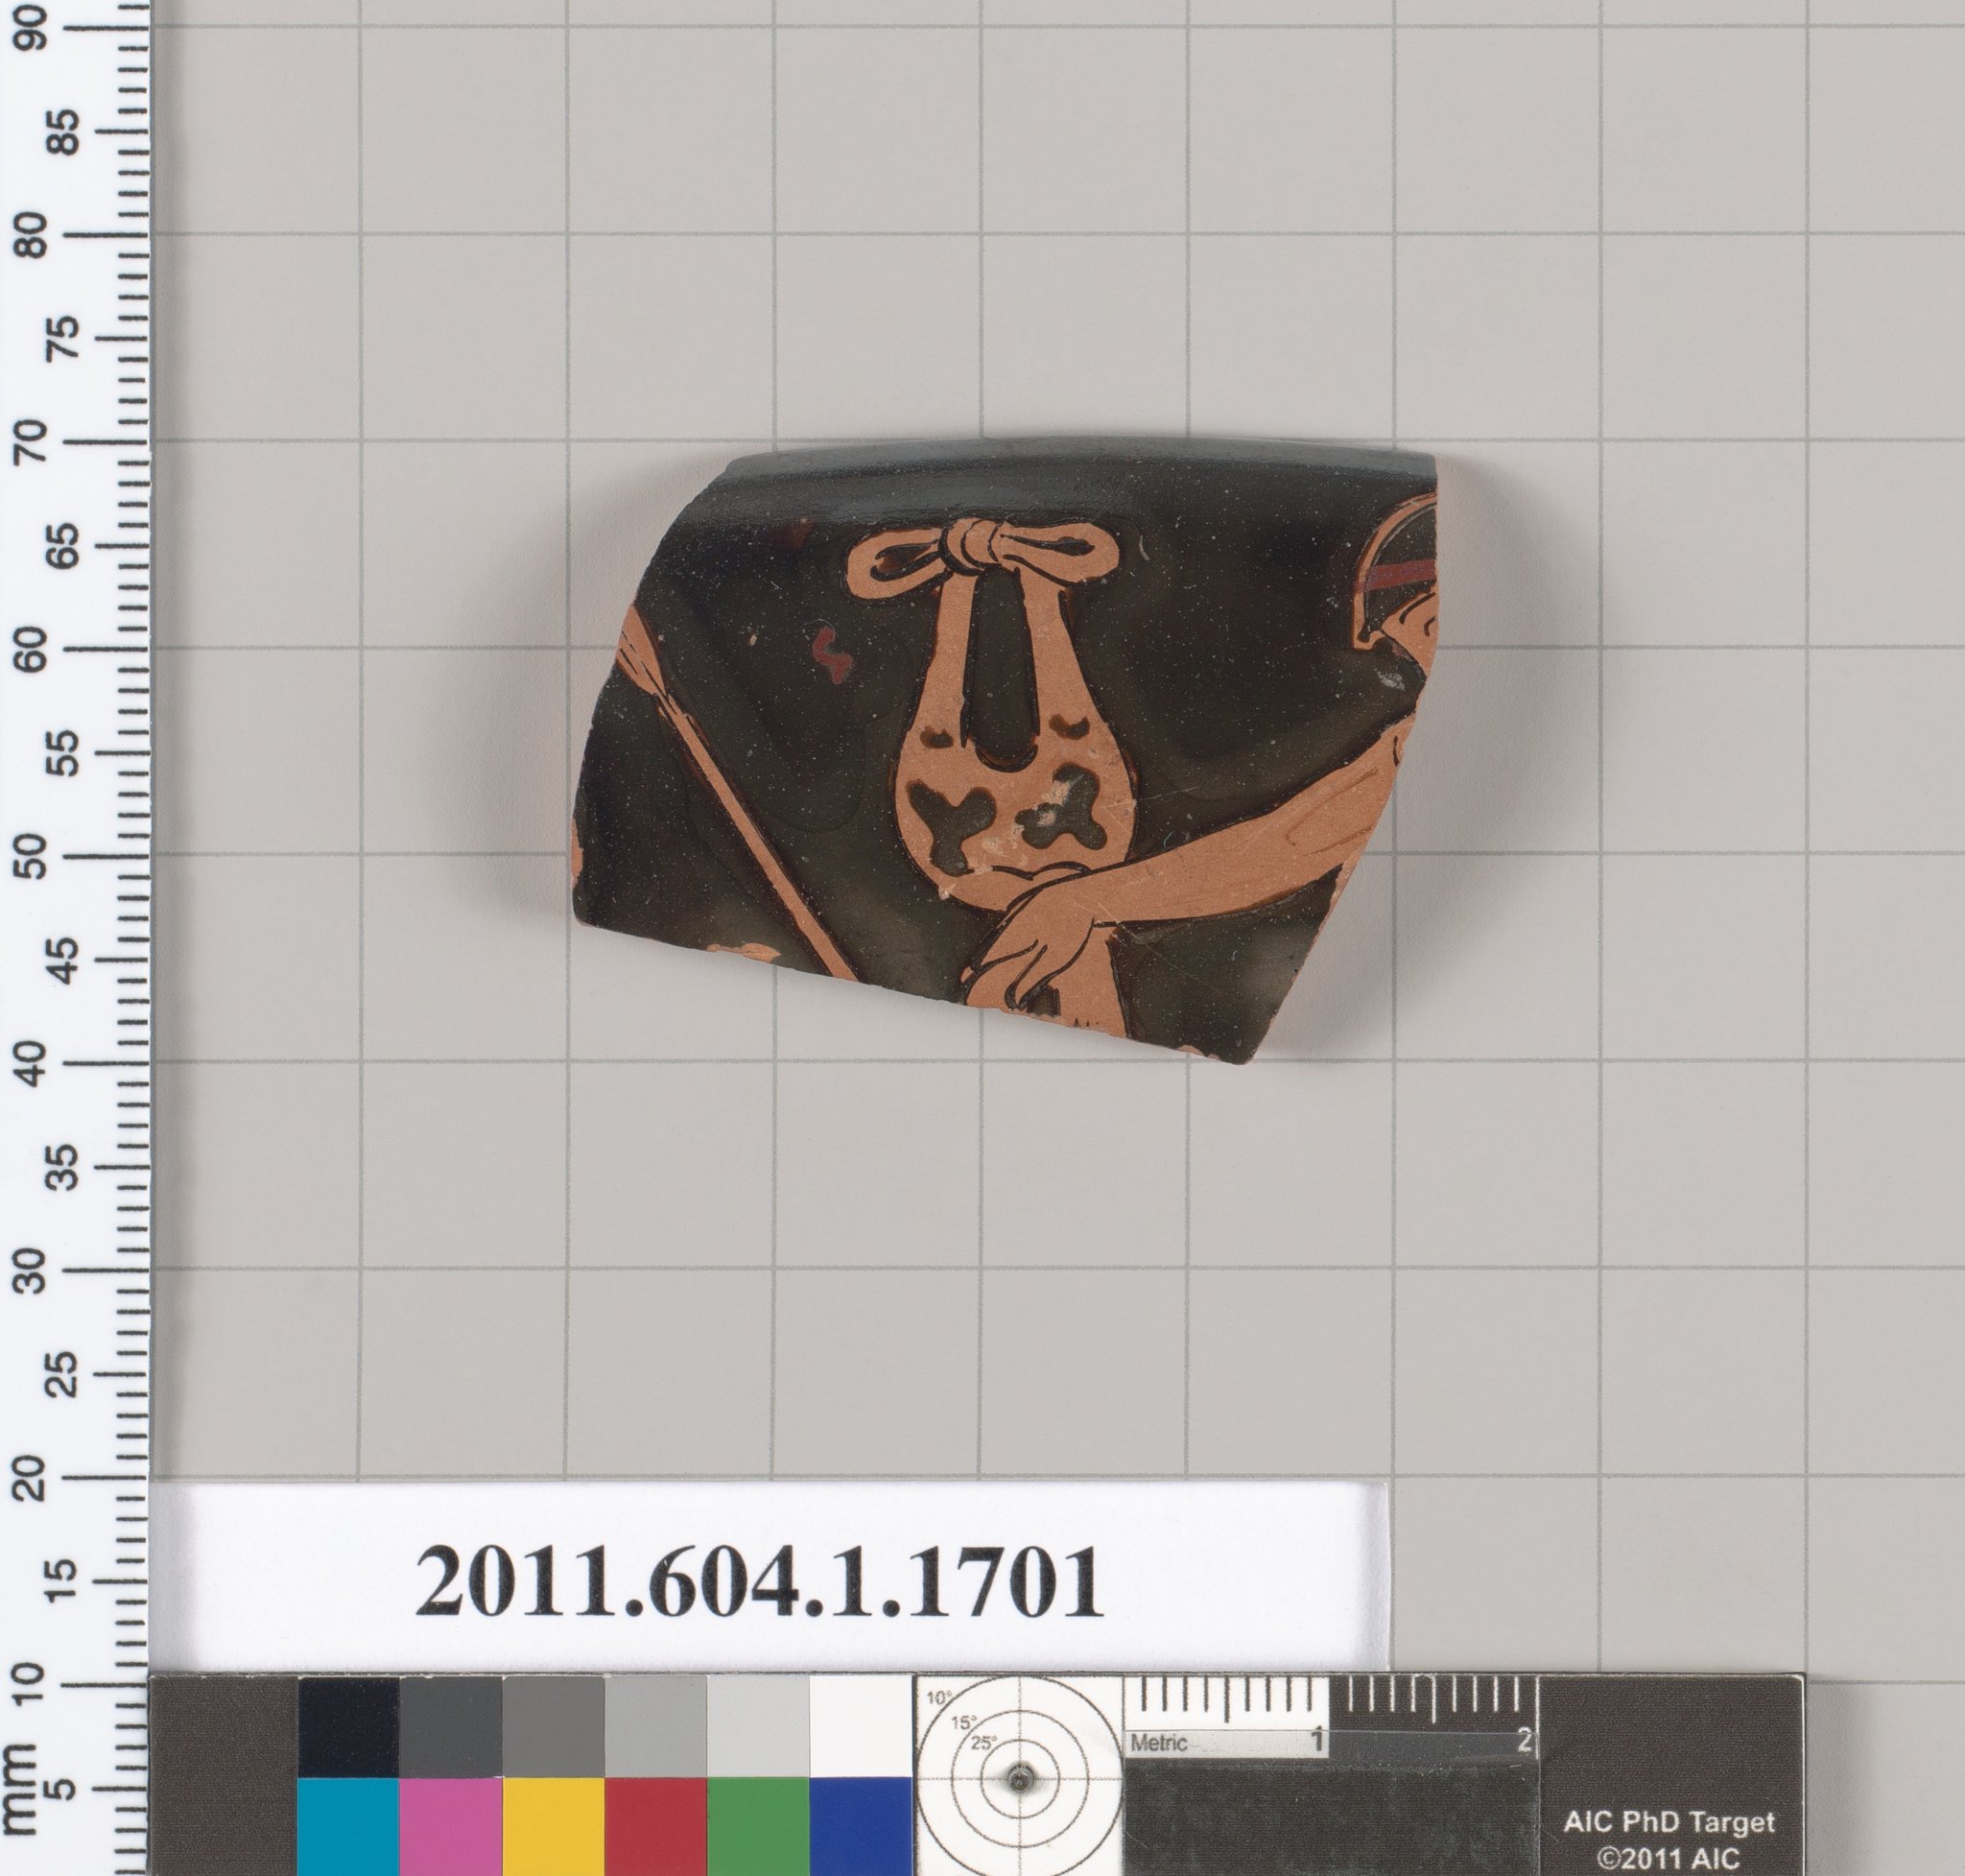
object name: kylix fragment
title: Terracotta rim fragment of a kylix (drinking cup)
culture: greek, attic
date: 490-480 BCE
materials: terracotta